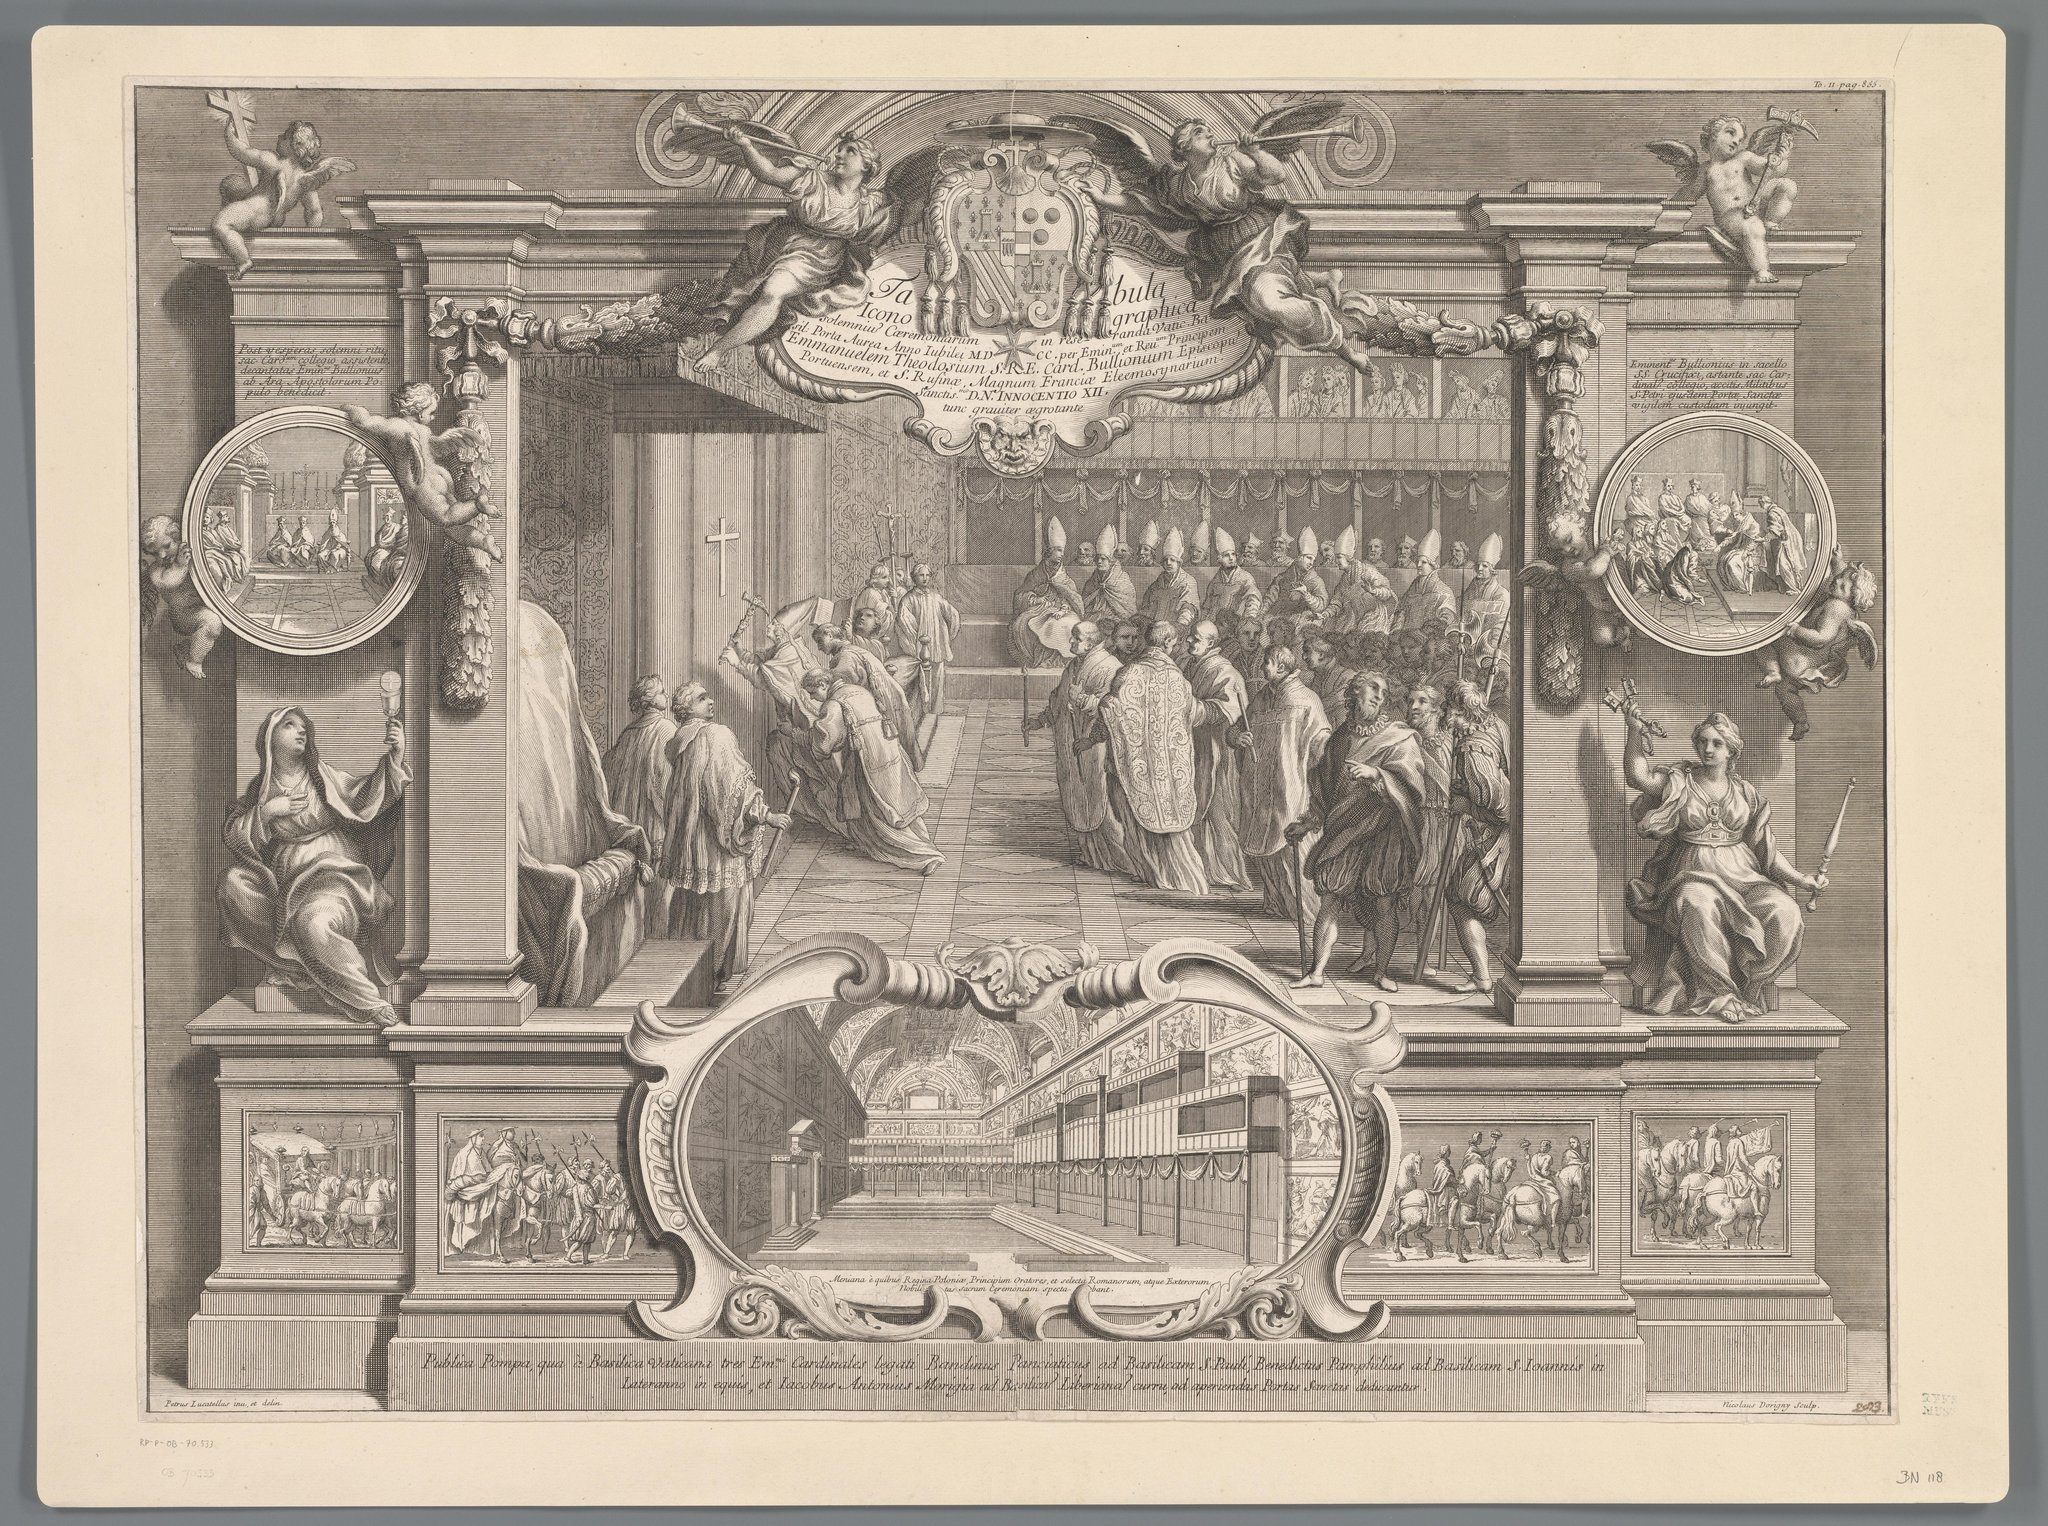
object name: book illustration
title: Ceremonie van het openen van de heilige deur in het jubeljaar 1700 door de kardinaal van Bouillon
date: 1700-1746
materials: paper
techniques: engraving, etching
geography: france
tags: rome, naples, clergyman, innocentius xii, tools, aids, implements ~ crafts and industries: hammer, opening the door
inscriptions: collector's mark: Lugt 240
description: Prent uit: onbekend boek, dl. 2, p. 855.